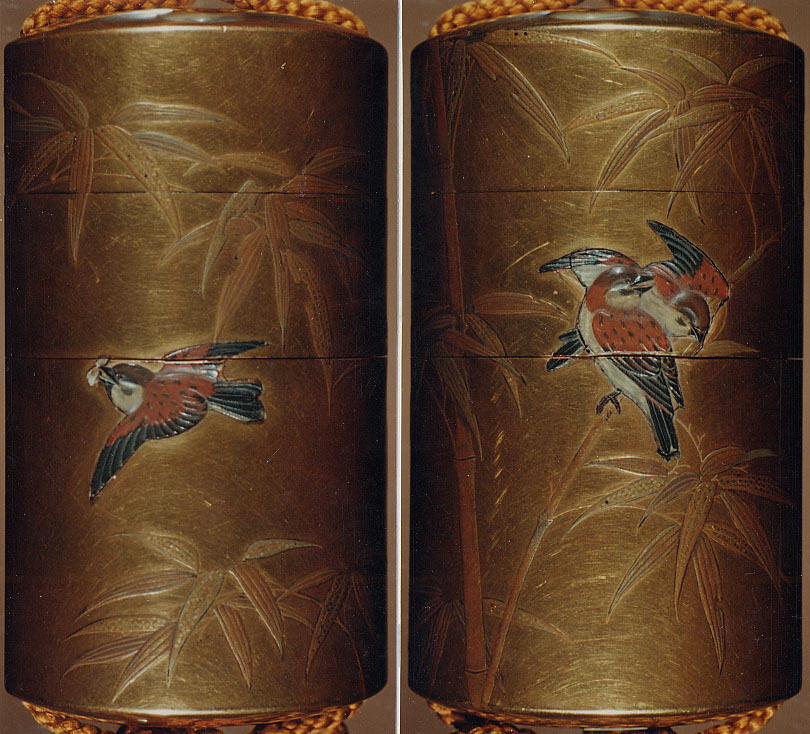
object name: inrō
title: Inrō with Sparrows and Bamboo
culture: japanese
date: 1834-1933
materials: bamboo, gold, gold foil, ivory, lacquer, metal, porcelain, silver, wood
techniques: hiramakie, inlay, lacquer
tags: birds,bamboo